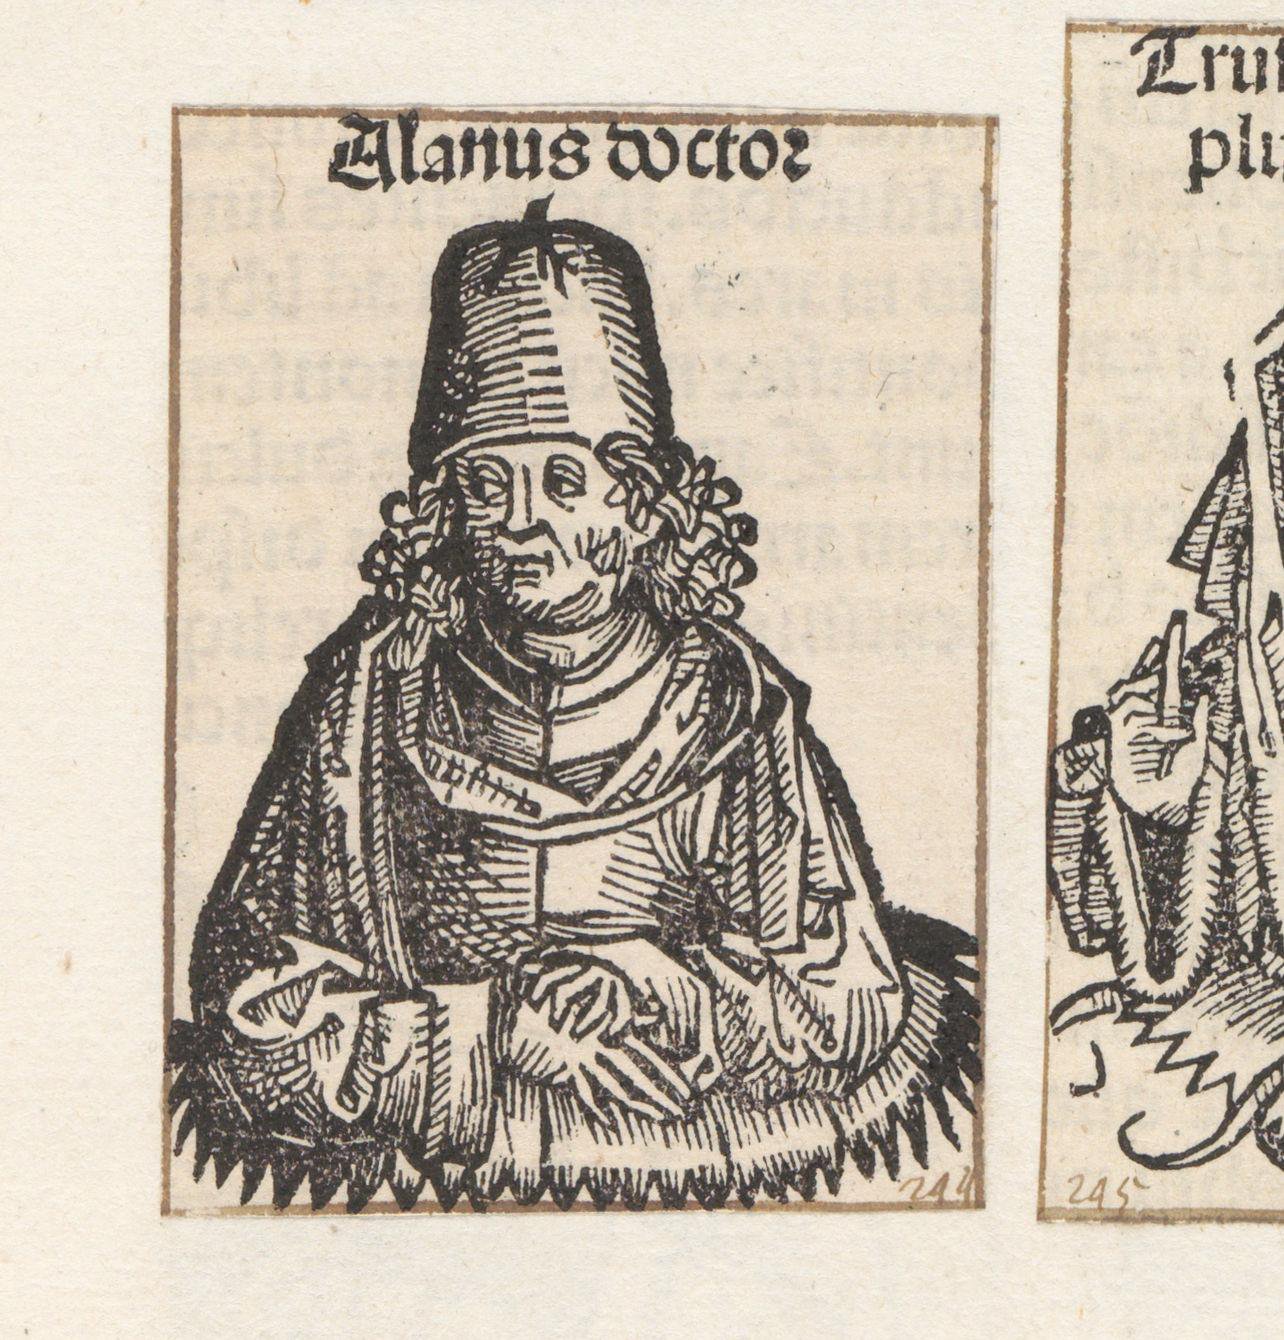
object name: print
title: Liber Chronicarum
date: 1493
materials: paper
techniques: letterpress printing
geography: nuremberg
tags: lille, saints, monk(s), friar(s)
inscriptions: inscription: ‘244’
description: De houtsnede wordt herhaaldelijk gebruikt als boekillustratie in de Liber Chronicarum (of Neurenbergkroniek) van Hartmann Schedel, verschenen in het Latijn en Duits in 1493. Zie de Latijnse uitgave, folio 221r.